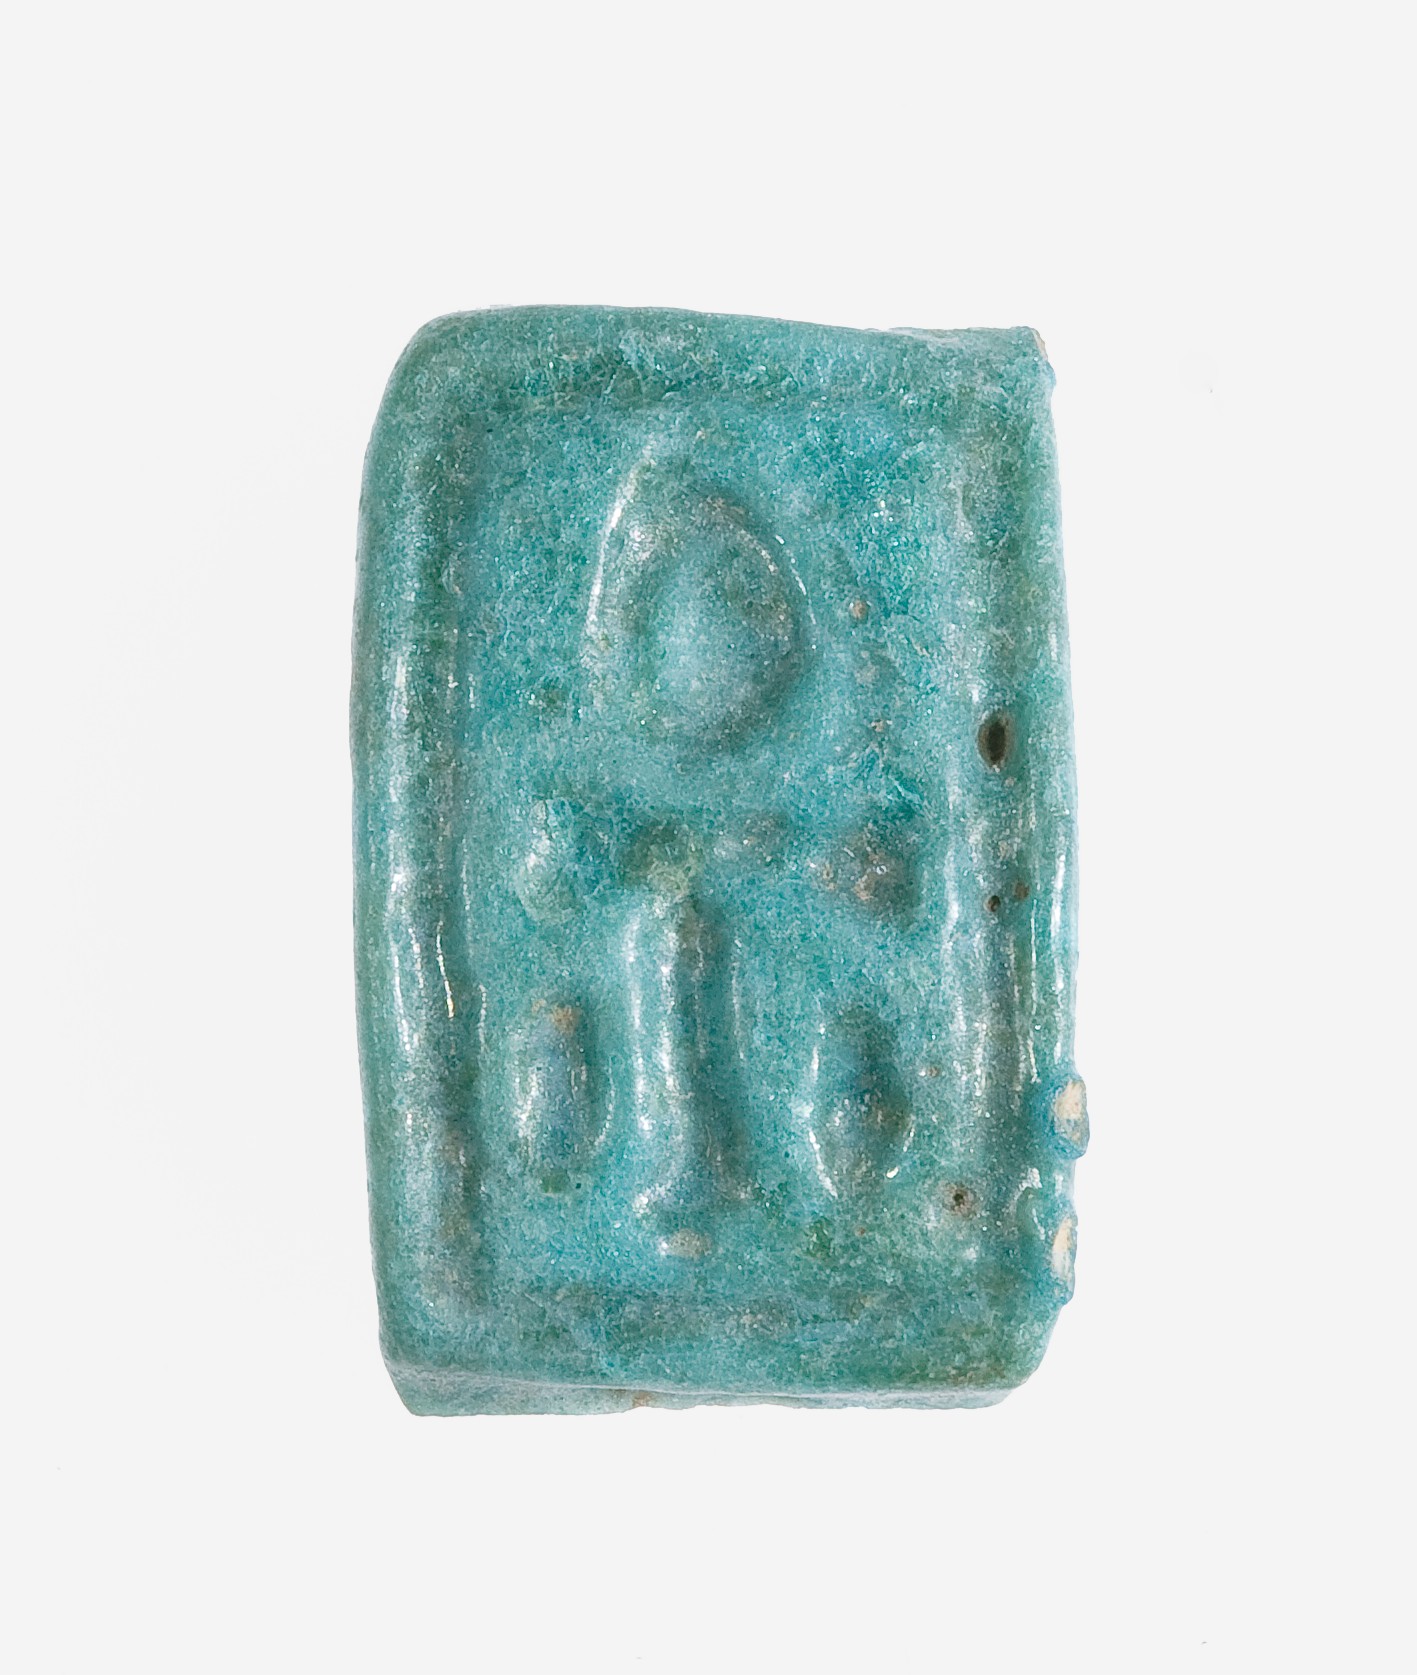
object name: ring fragment, ankh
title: Ring Fragment Inscribed with an Ankh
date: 1390-1352 BCE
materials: faience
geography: egypt